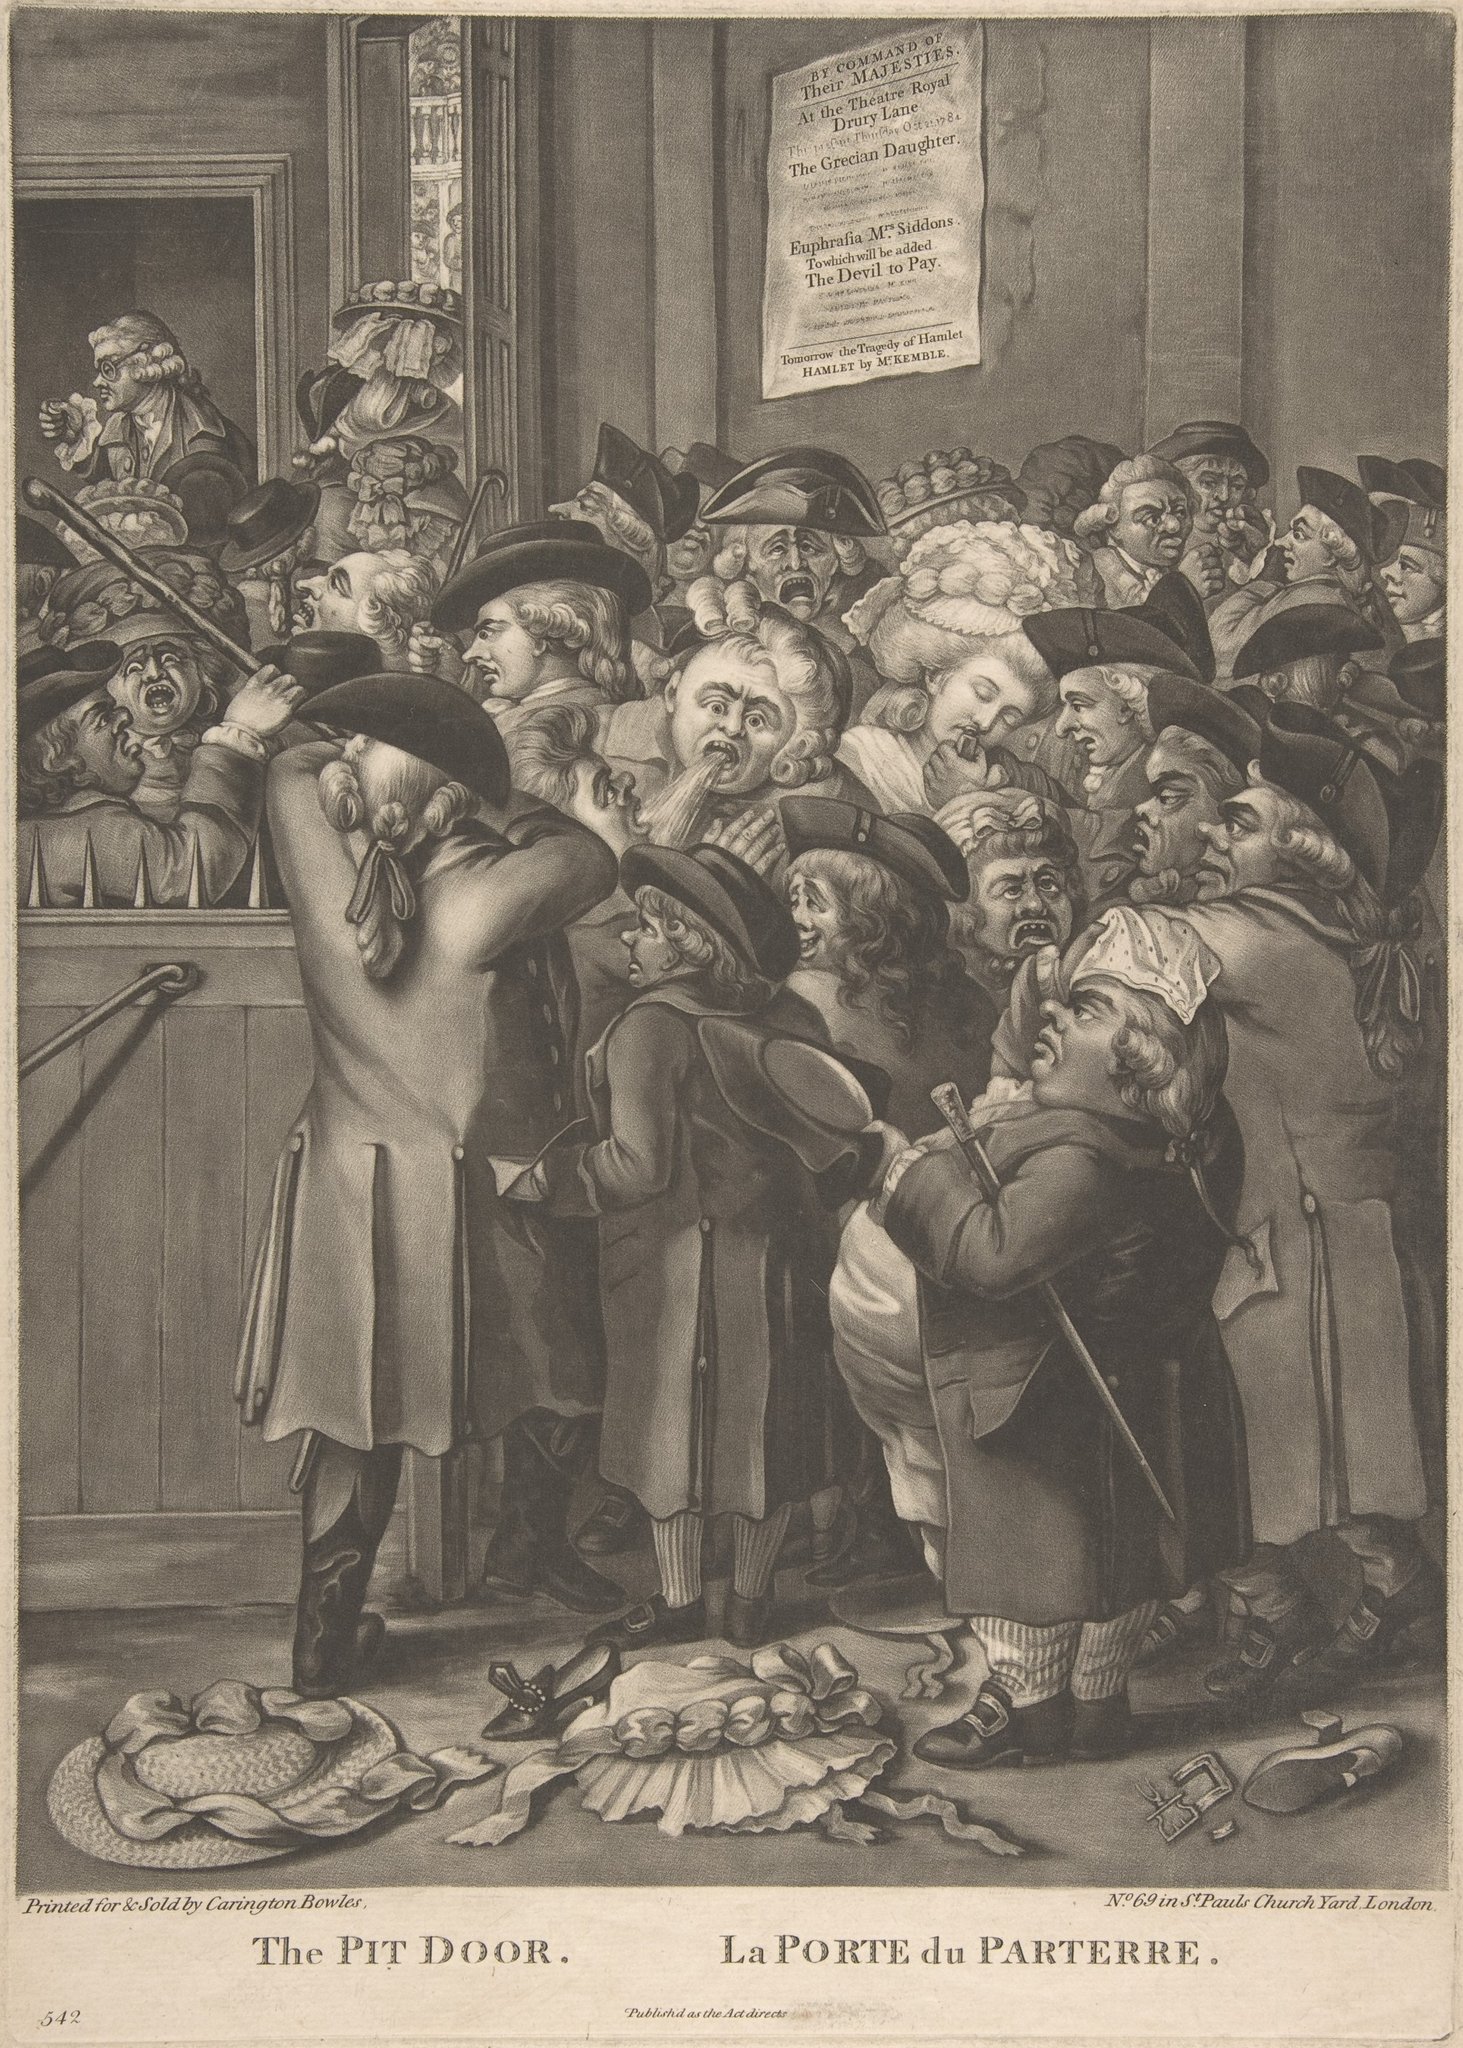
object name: print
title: The Pit Door / La Porte du Parterre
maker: robert dighton the elder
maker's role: artist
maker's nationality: british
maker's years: 1751-1814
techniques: mezzotint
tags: men,women,crowd